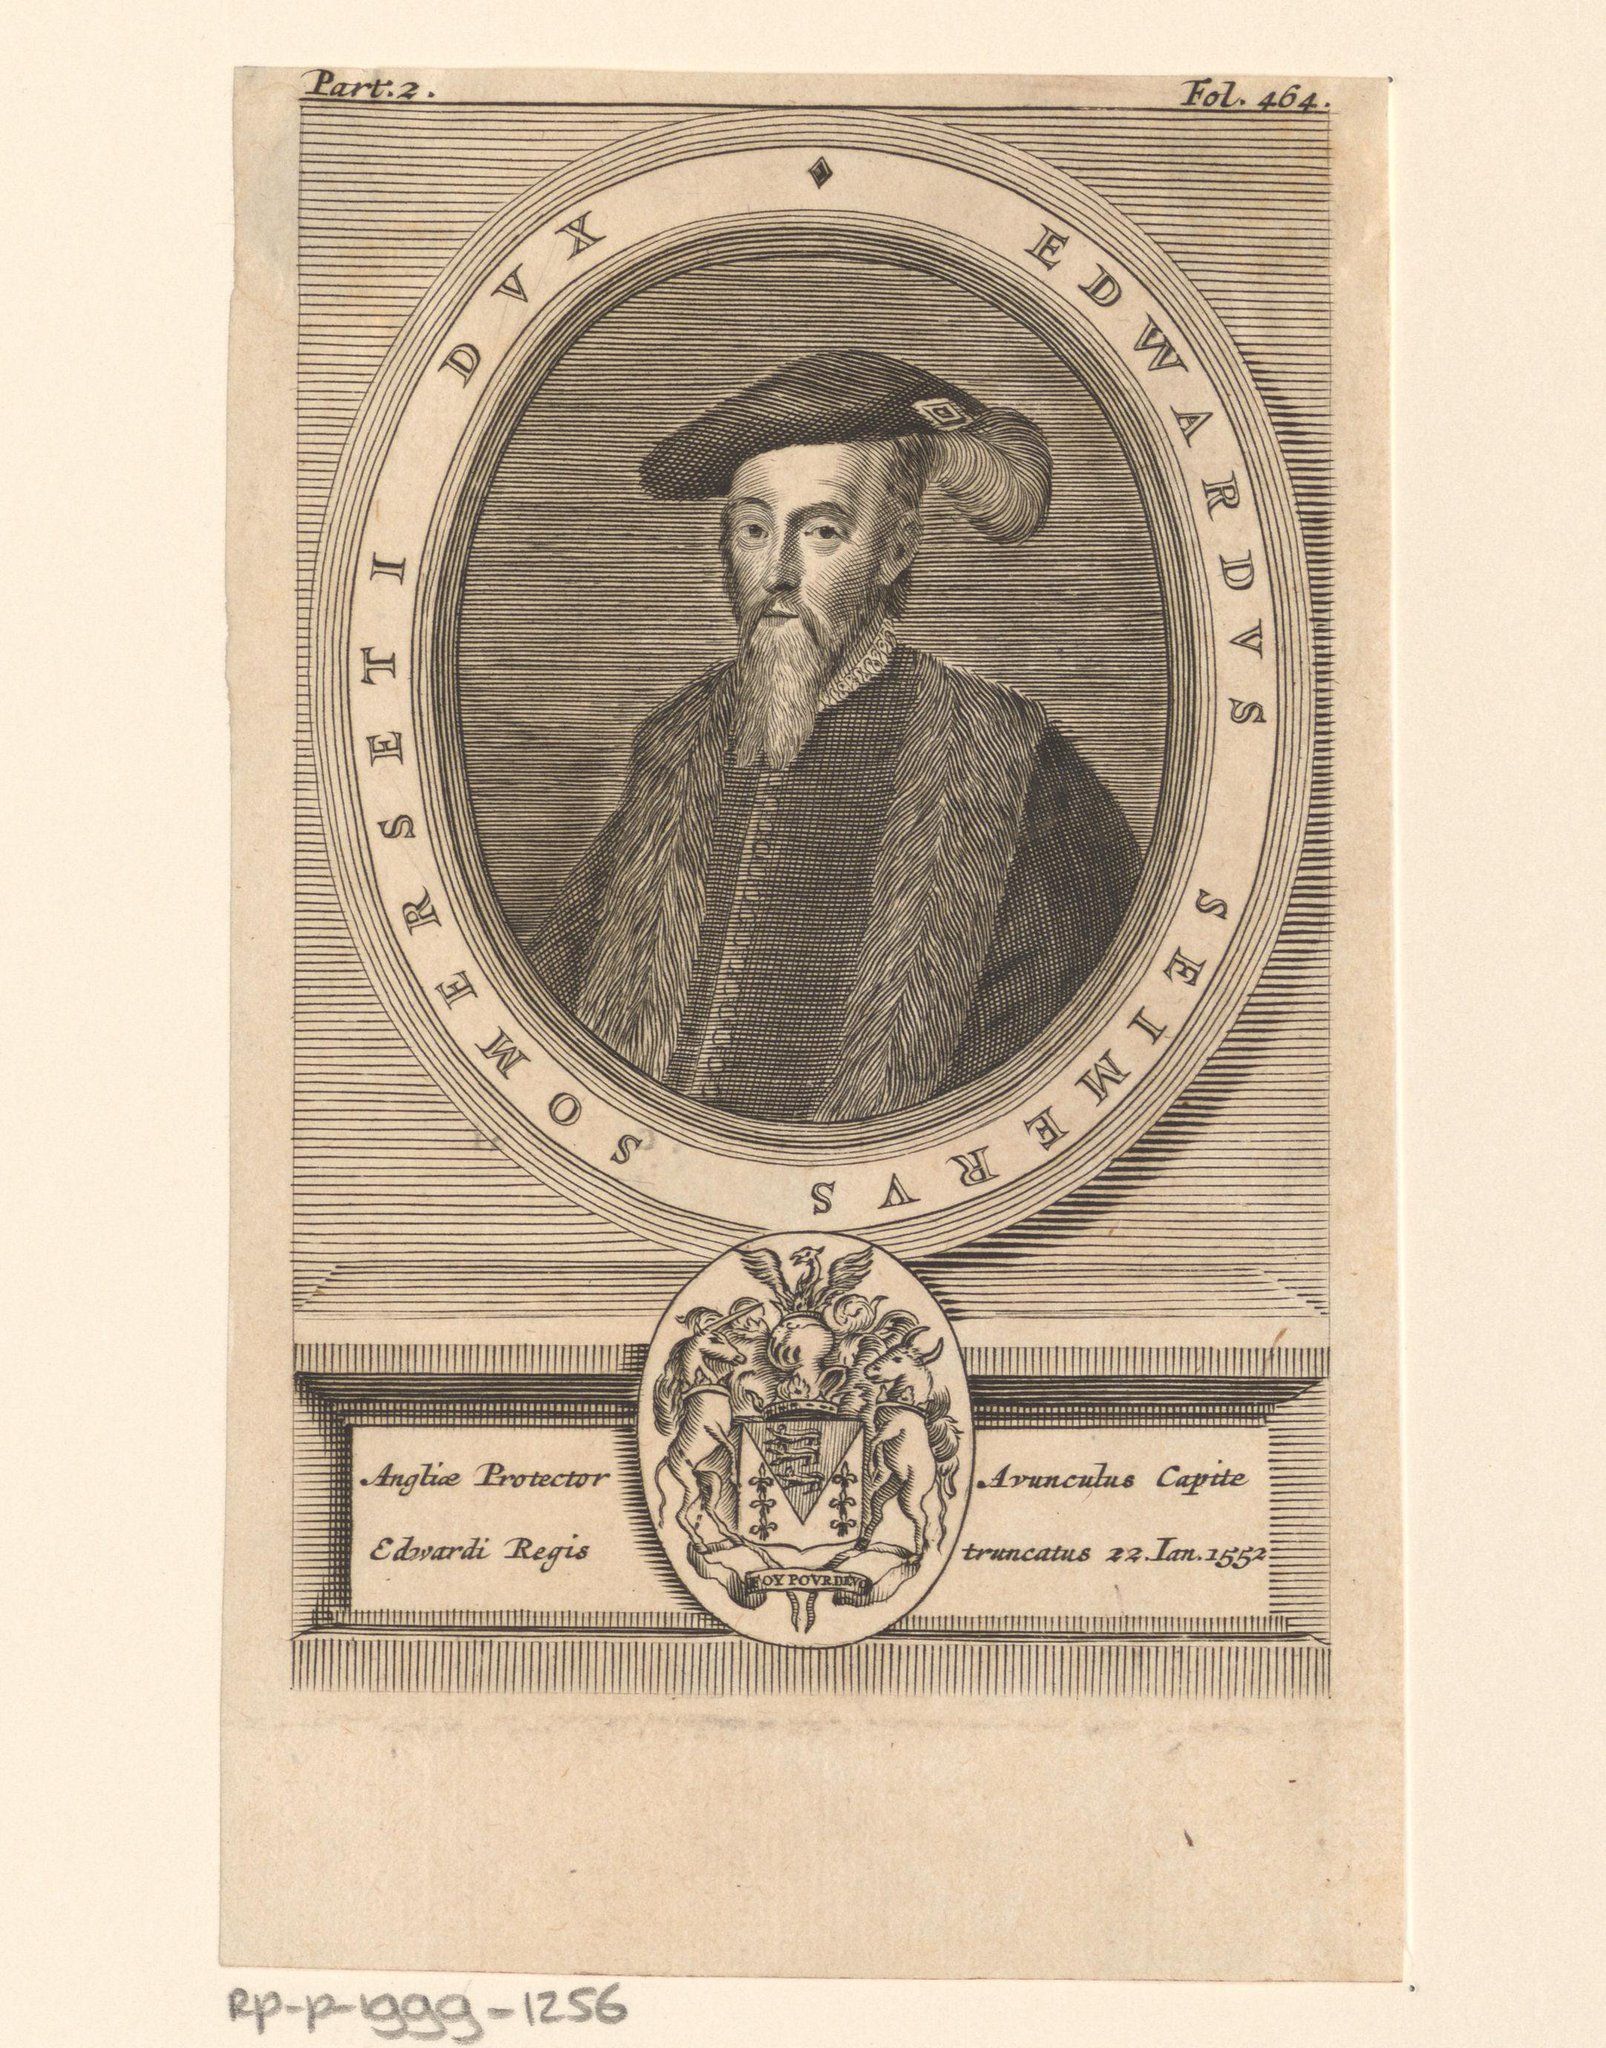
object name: print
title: Portret van Edward Seymour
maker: Anonymous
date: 1687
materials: paper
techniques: engraving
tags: historical persons, armorial bearing, heraldry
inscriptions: collector's mark: Lugt 2760, collector's mark: Lugt 2228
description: Prent waarschijnlijk uit: Burnet, Gilbert en Jean Baptiste de Rosemond. Histoire de la réformation de l'église d'Angleterre. Amsterdam: Abraham Wolfgang, 1687, dl. 2.1.